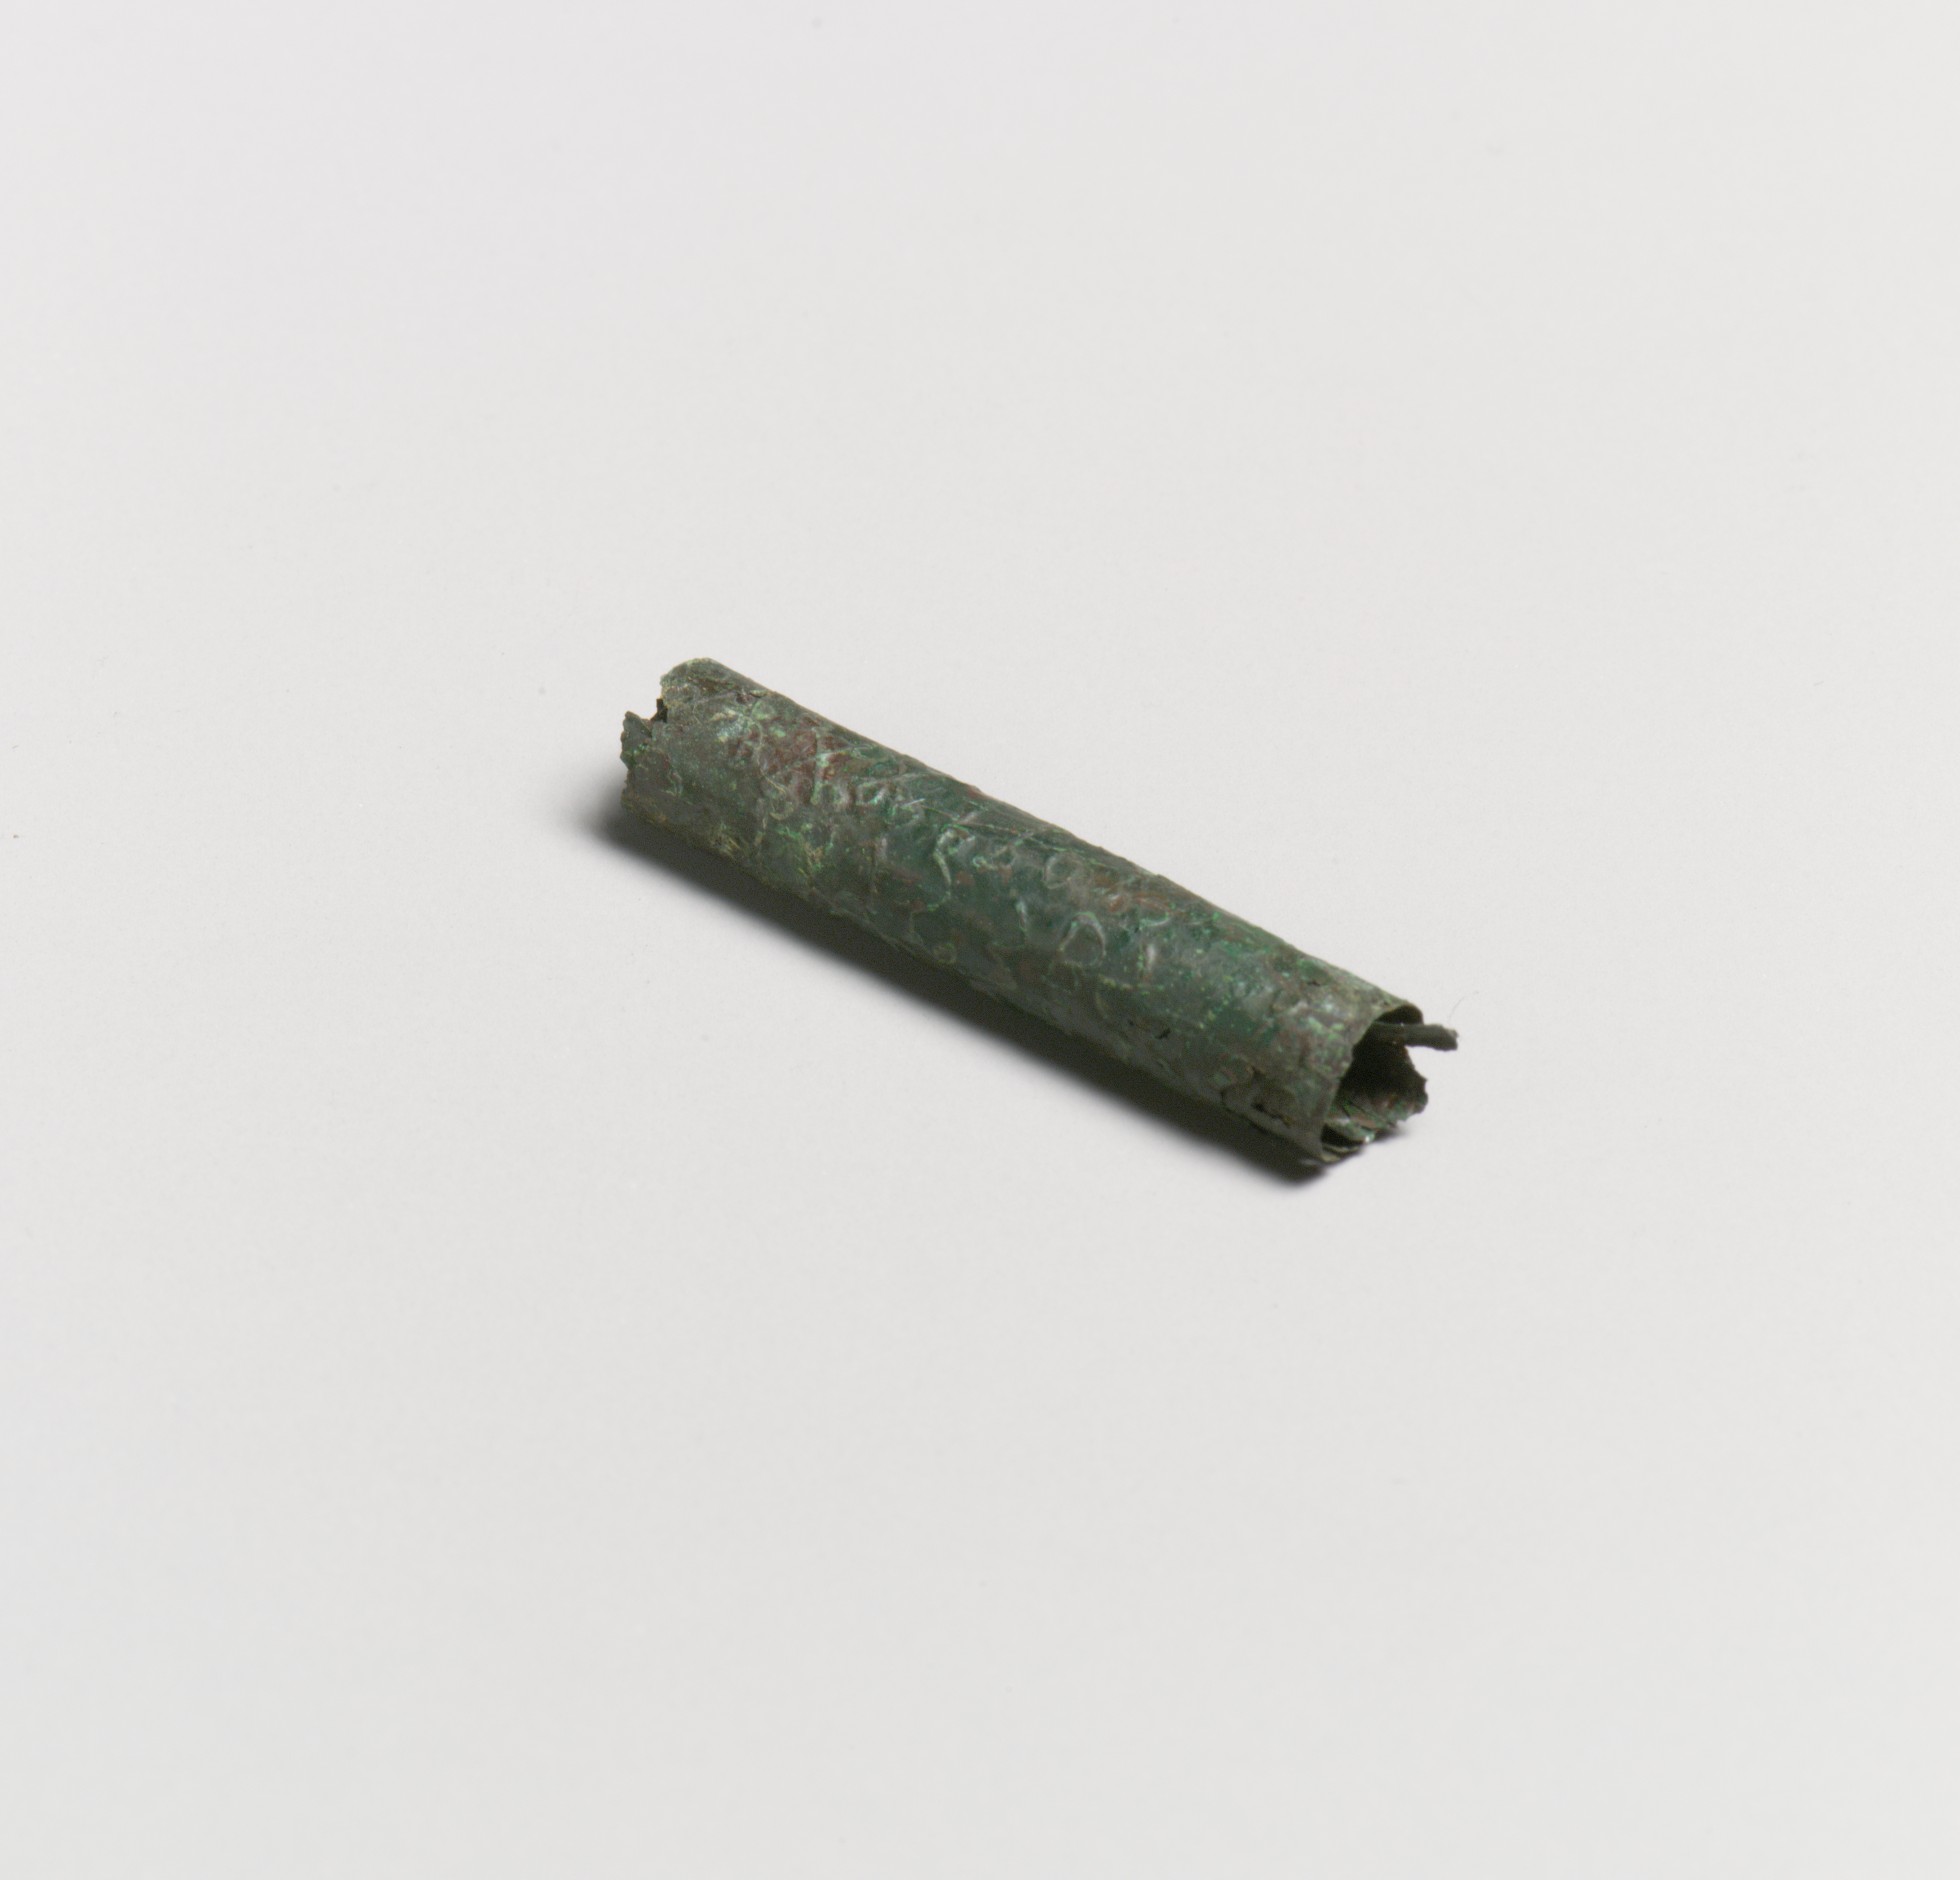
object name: scroll, inscribed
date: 7000 BCE-330 CE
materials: bronze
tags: scrolls